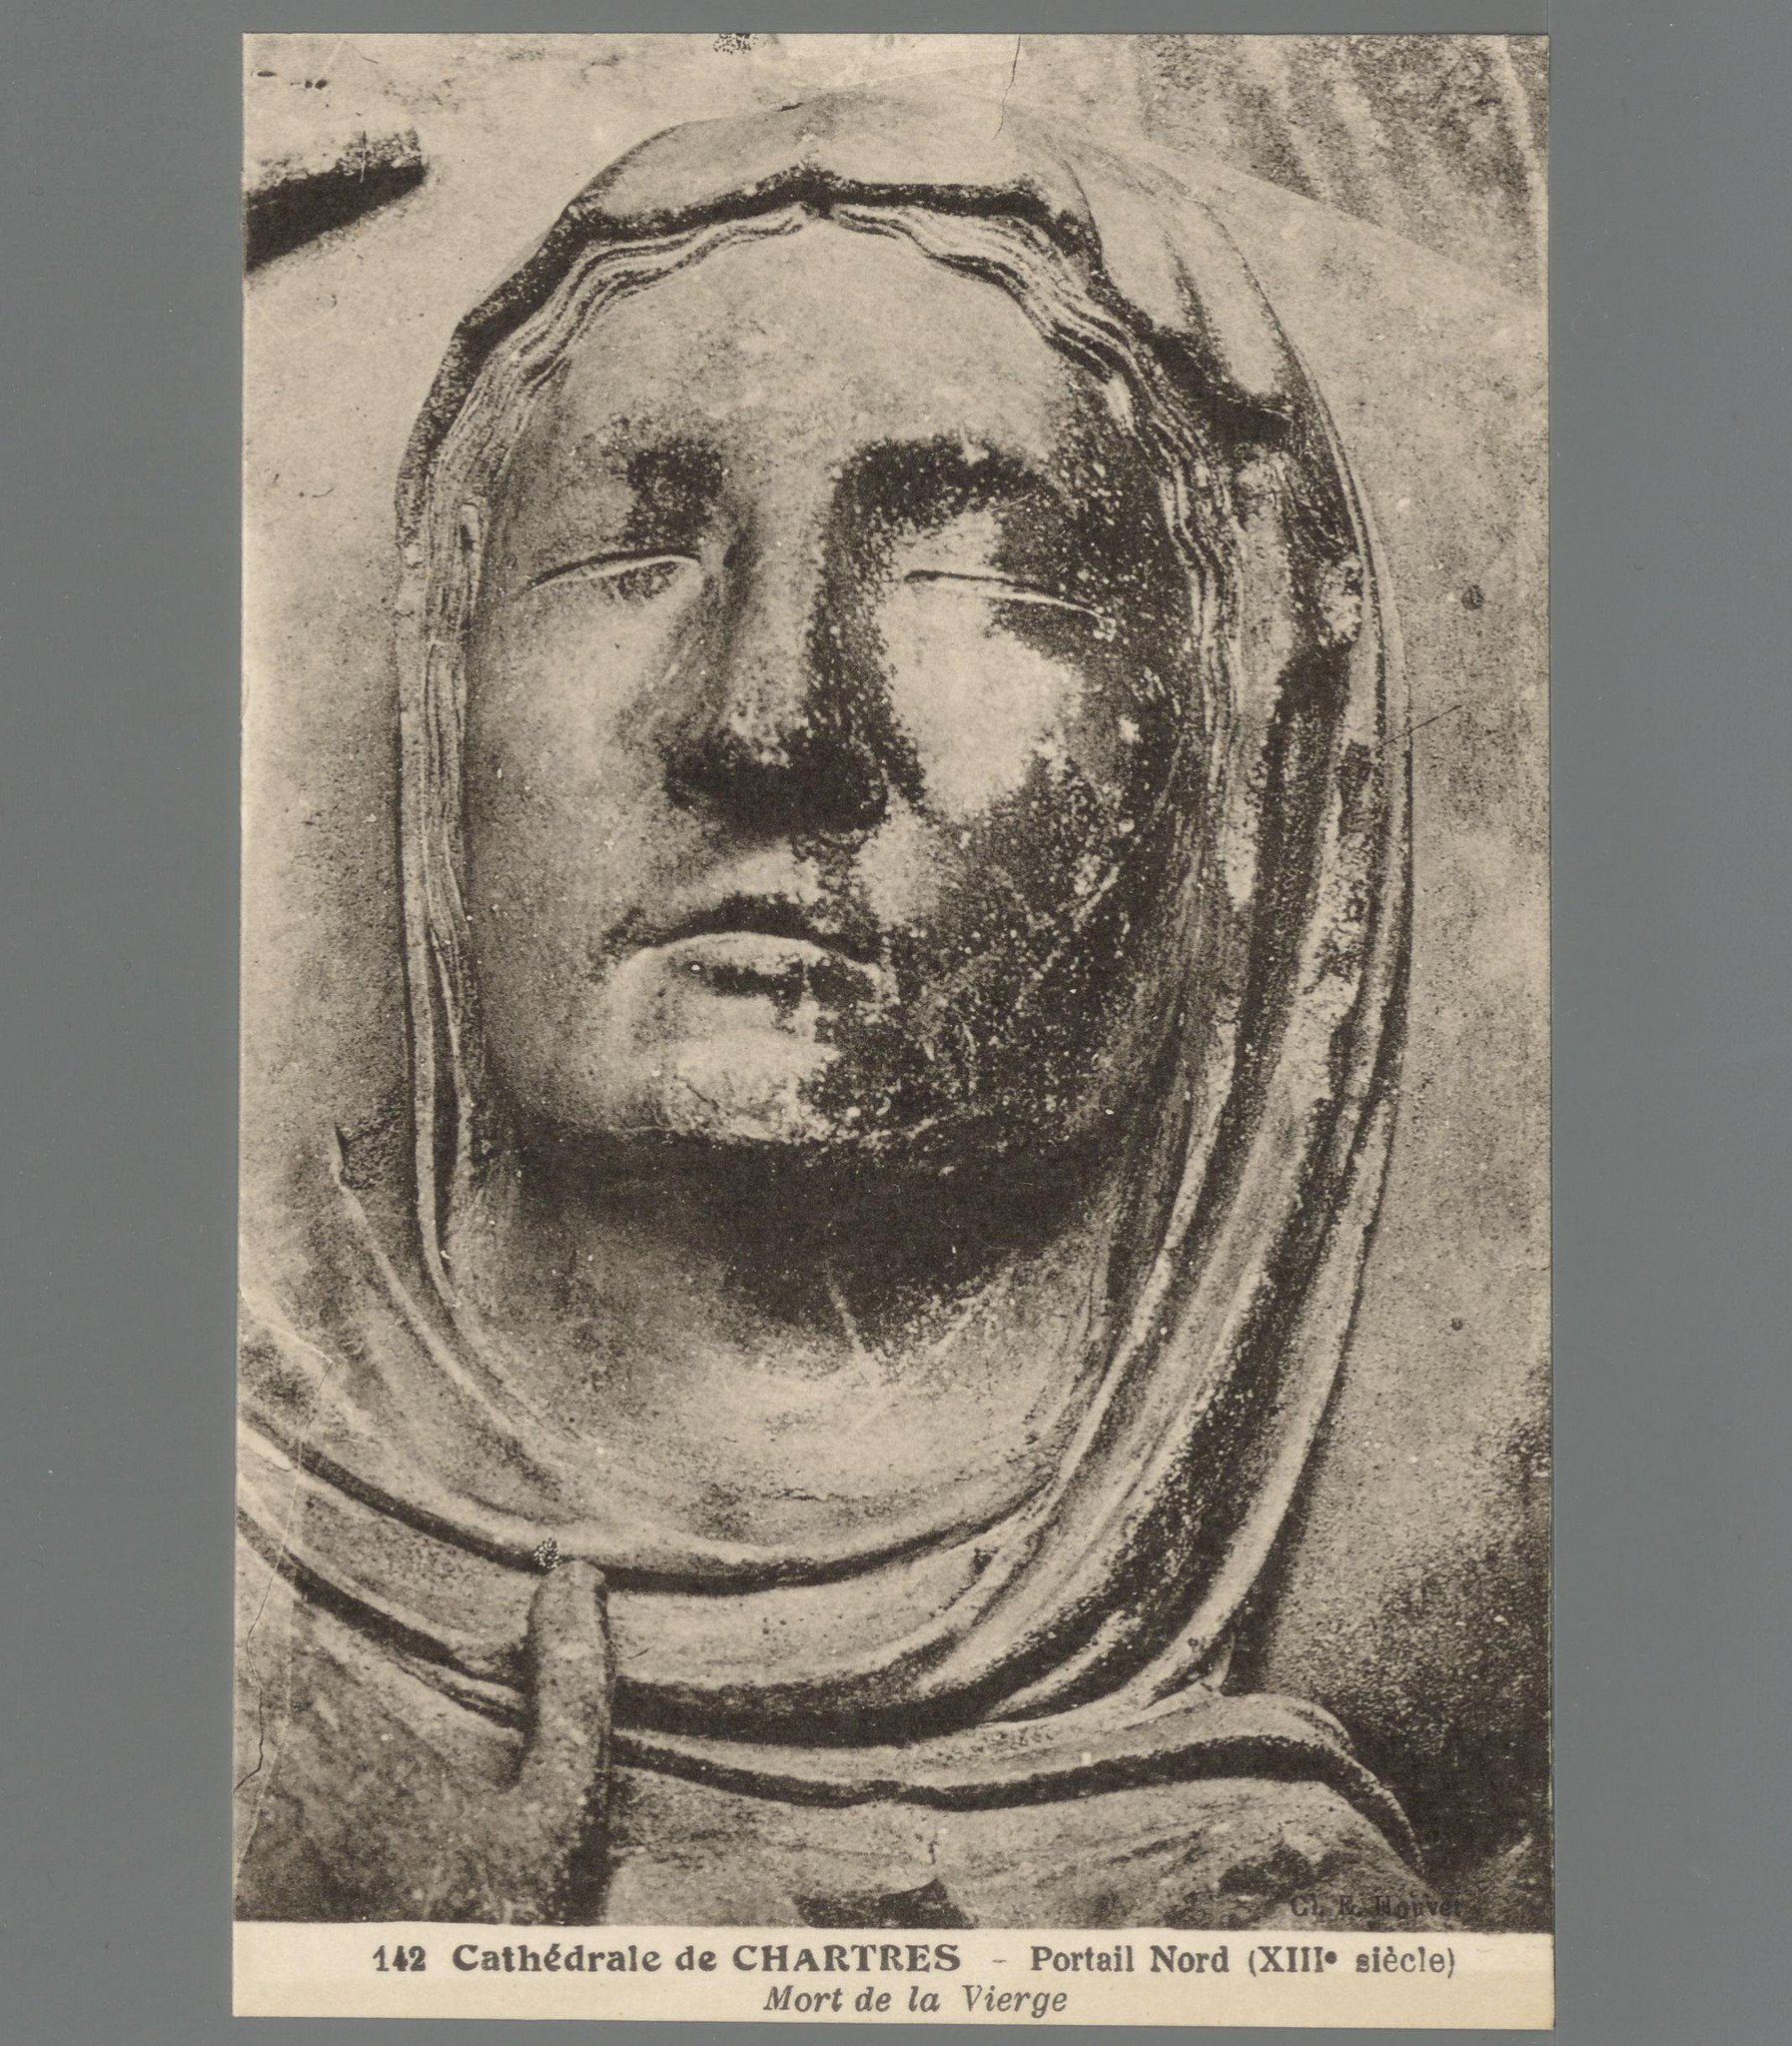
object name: ansichtkaart, prentbriefkaart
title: Cathédrale de Chartres - Portail Nord (XIIIe siècle). Mort de la Vierge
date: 1903-1930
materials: cardboard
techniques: photograph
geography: chartres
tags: church (exterior), statues, paintings, etc. ~ objects of worship in roman religion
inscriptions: collector's mark: ‘AFE v S’